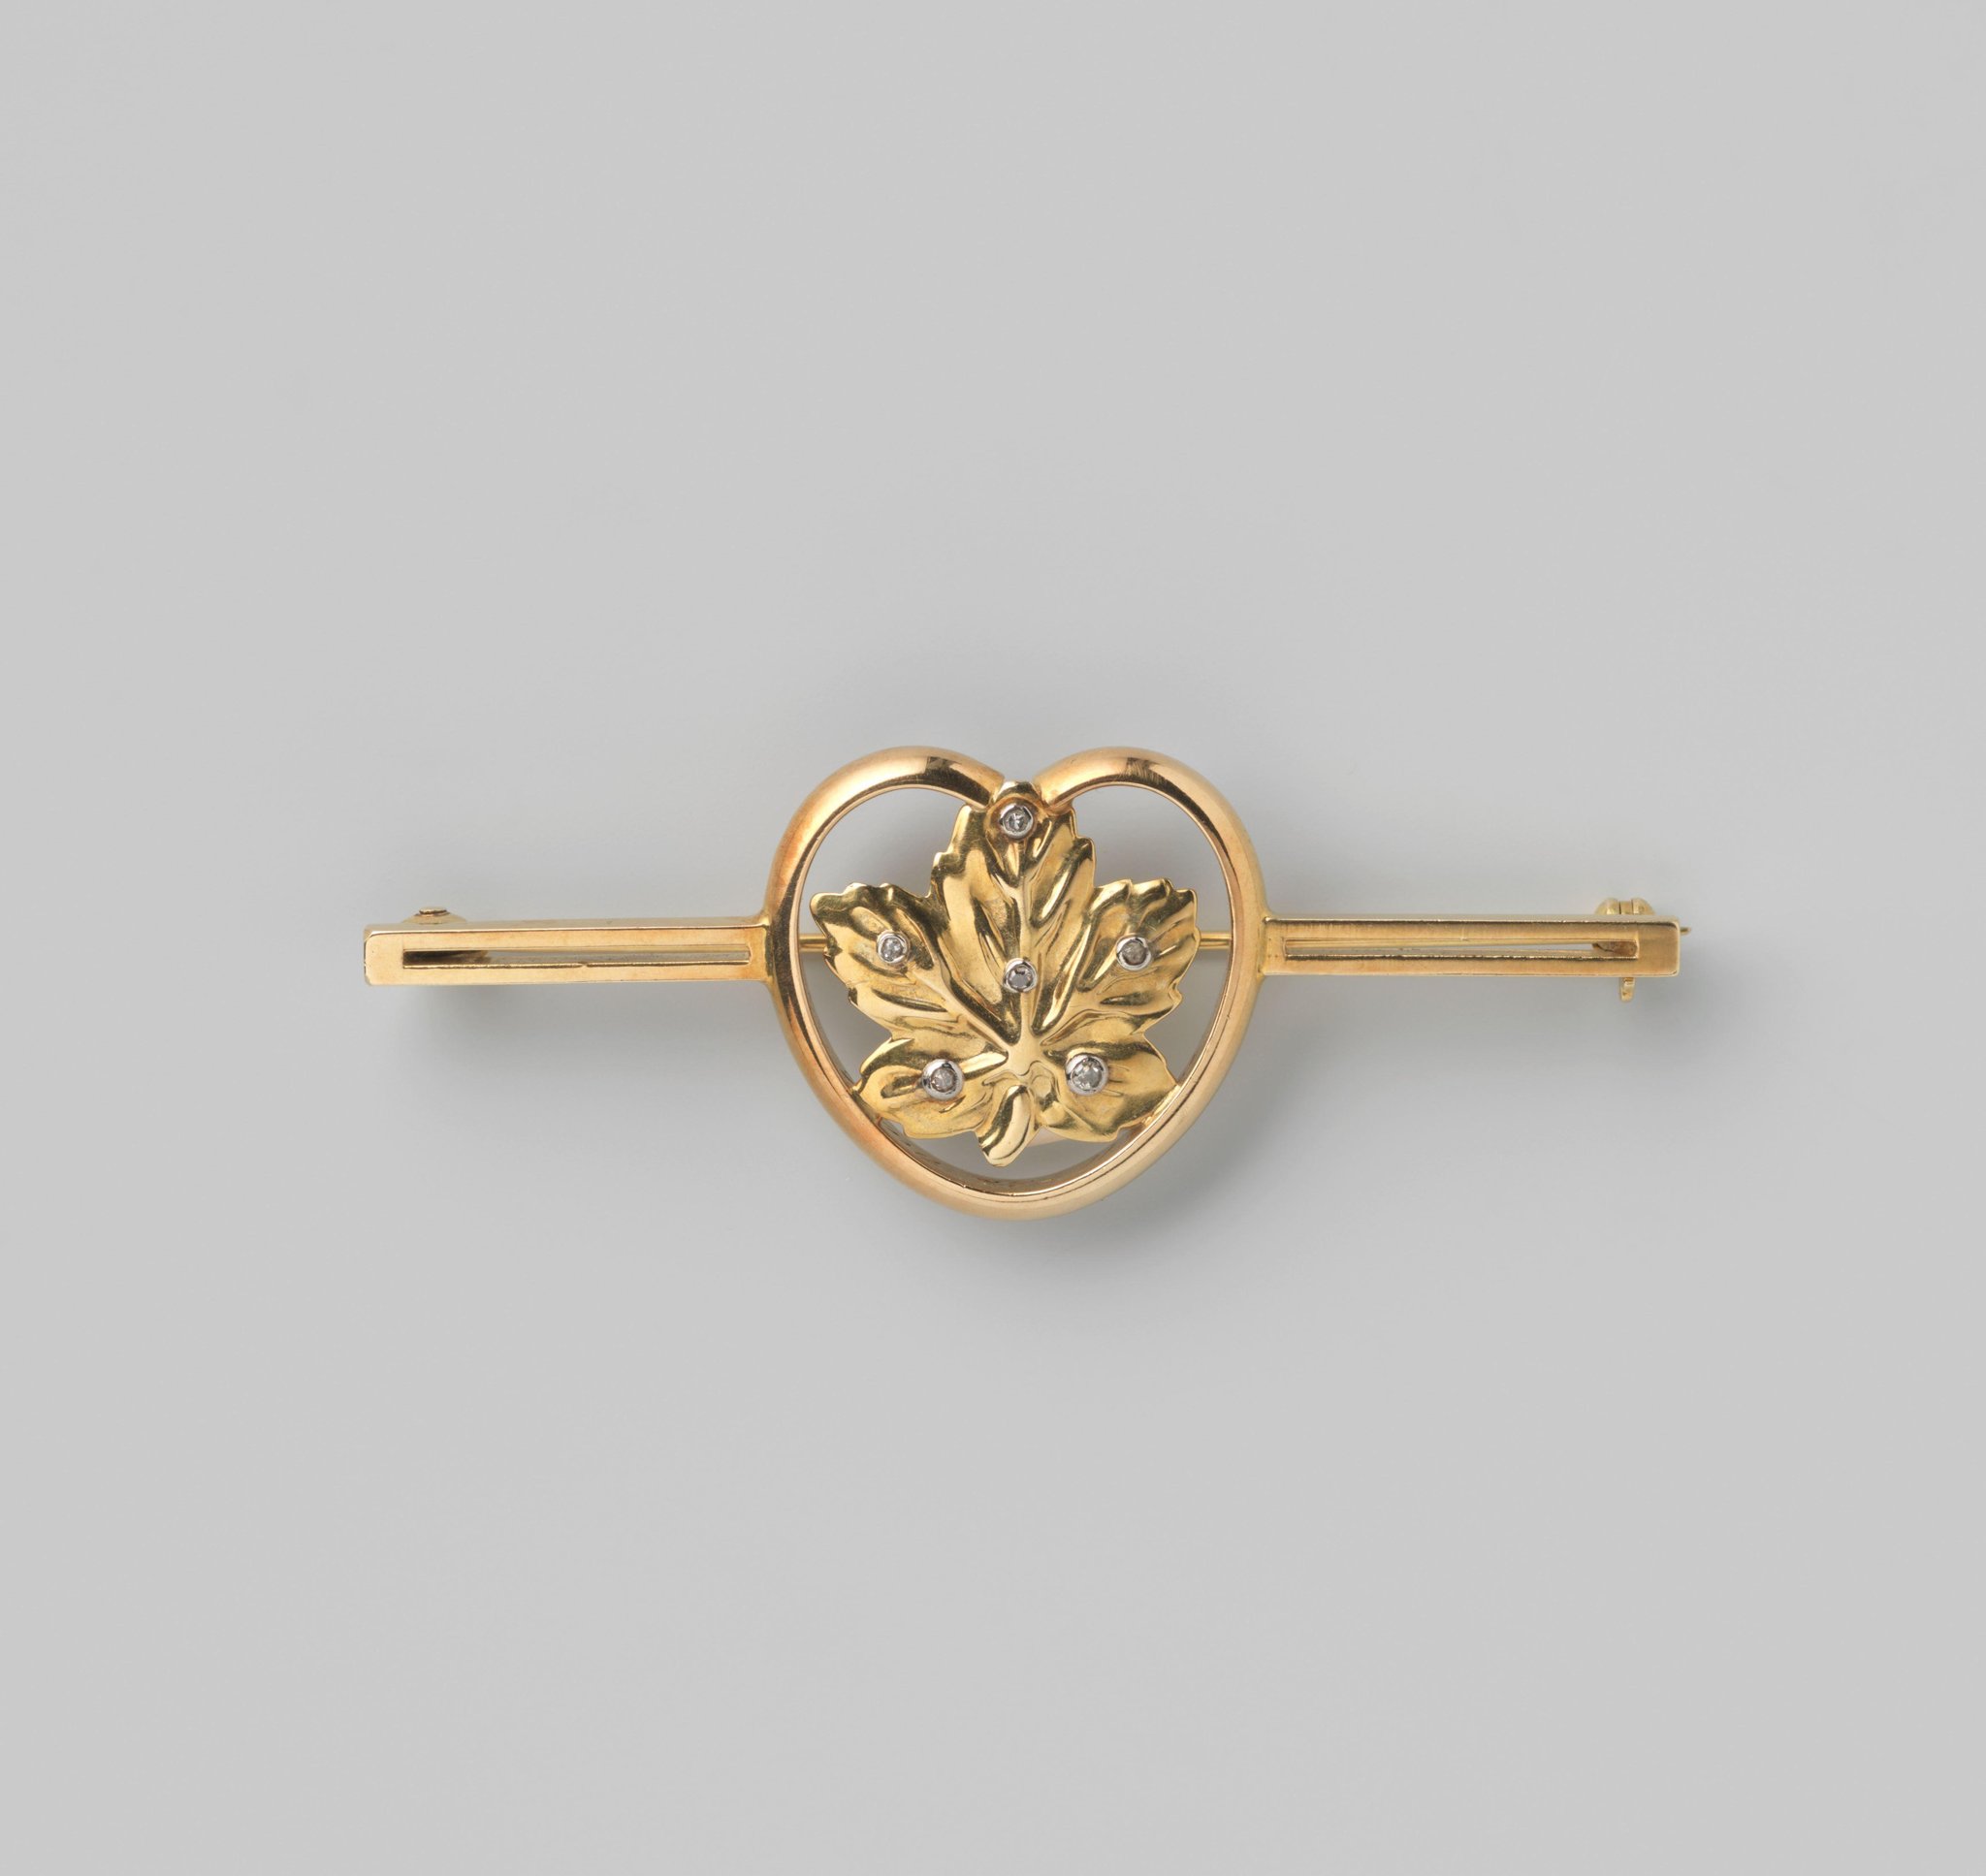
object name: wedding ring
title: Brochette van goud met diamant en hergebruikte trouwring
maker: Anonymous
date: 1960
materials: diamond, gold, paste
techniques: faceting, sawing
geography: netherlands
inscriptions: inscription: ‘Leny 27-11-'24’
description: Brochette van goud met twee diamanten achtkant, twee pastes en één gefacetteerde diamant en hergebruikte trouwring voorzien van een kogelsluiting. Centraal een eikenblad waarop zes diamanten, dit blad is gevat in de trouwring die tot hart is getransformeerd.